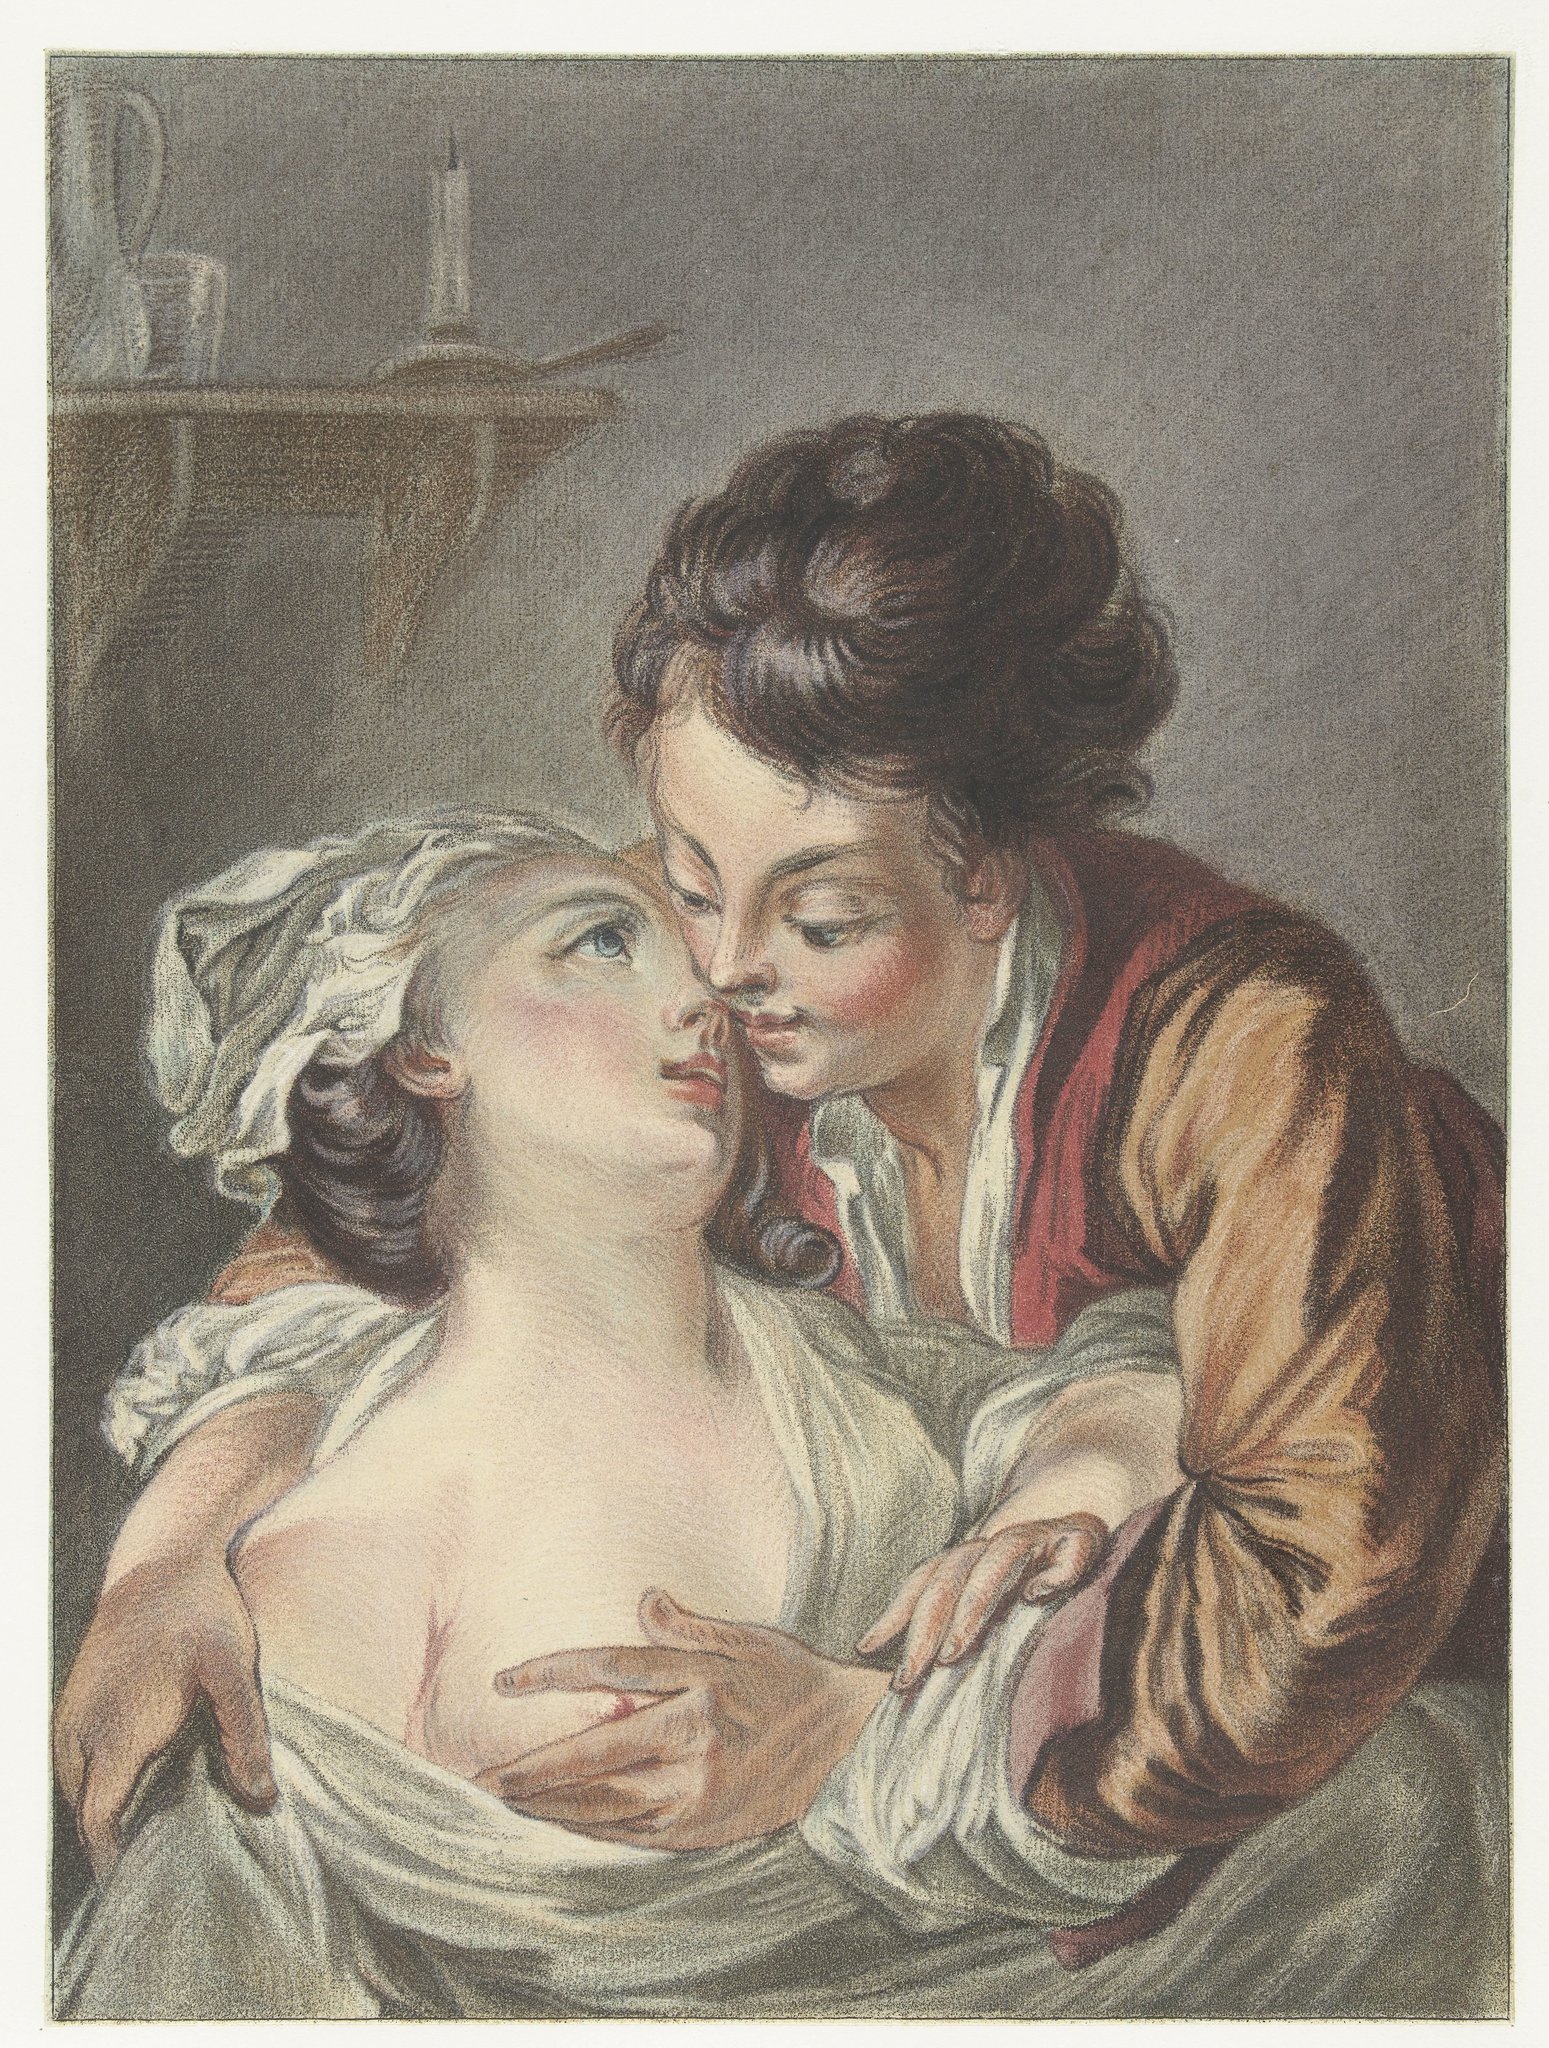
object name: print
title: Le Rendez-Vous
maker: louis marin bonnet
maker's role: print maker, publisher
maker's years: 1736-1793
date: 1771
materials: paper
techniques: printing, drawing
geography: paris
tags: (lovers) kissing each other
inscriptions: collector's mark: Lugt 2228, inscription: ‘Beaudoin pinxit Le rendes vous L. Bonnet sculpsit 1771’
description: Een man een een vrouw staan op het punt te elkaar te kussen. De man heeft zijn armen om de vrouw geslagen en heeft haar ontblote borst vastgepakt.